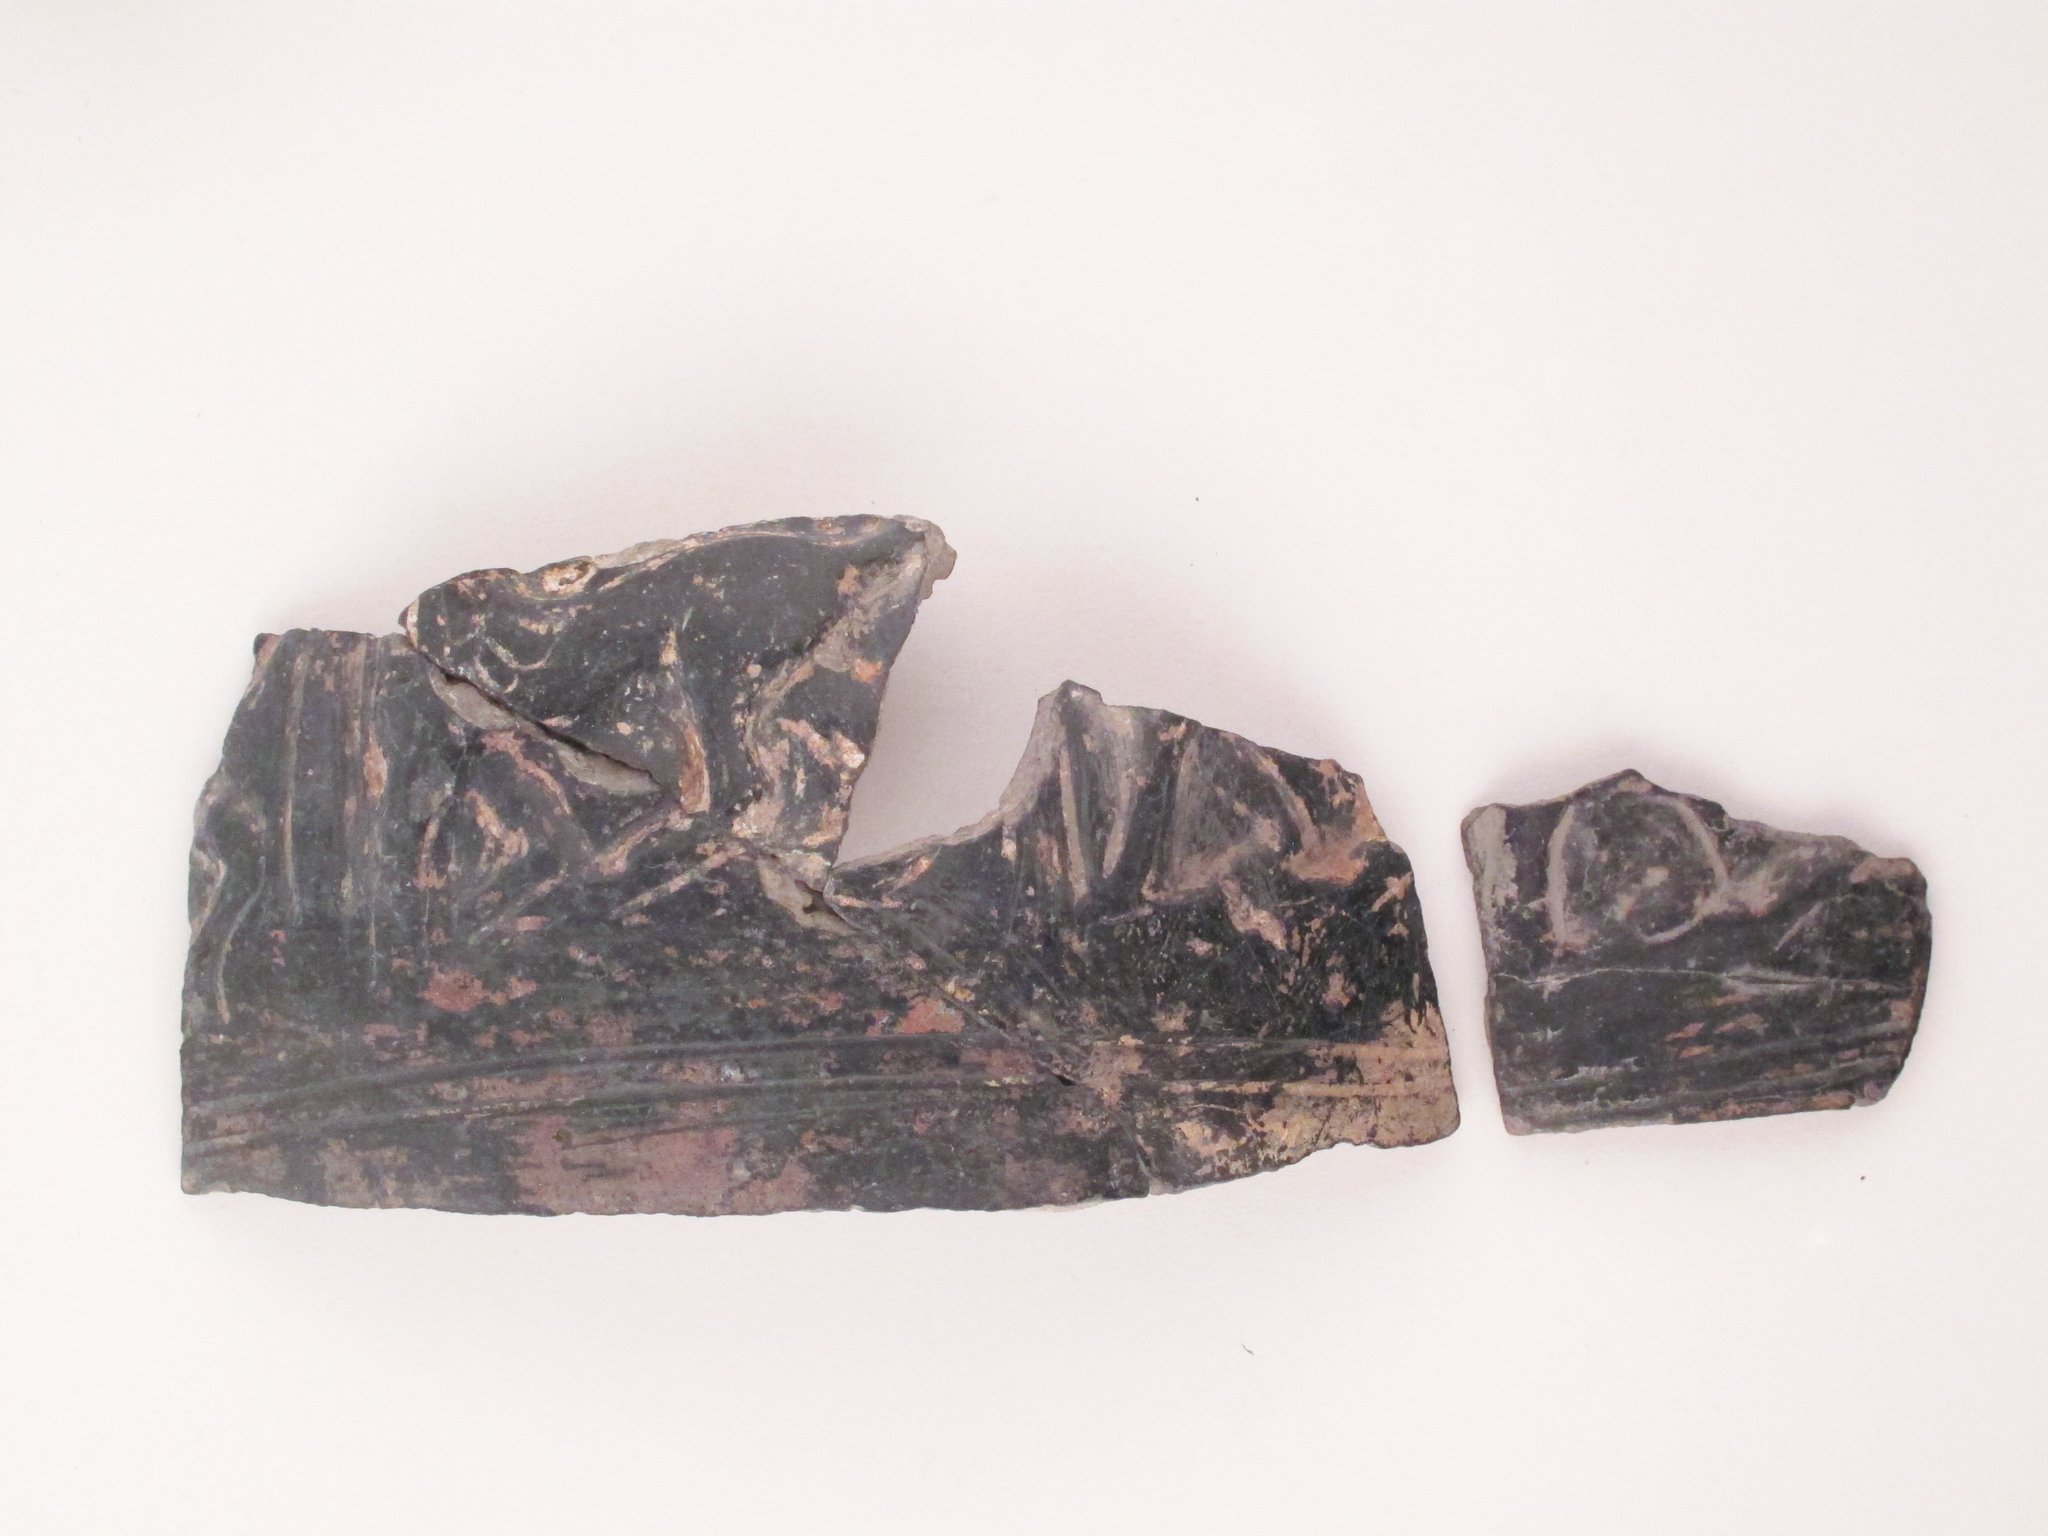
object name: vase fragment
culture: etruscan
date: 575-550 BCE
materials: terracotta